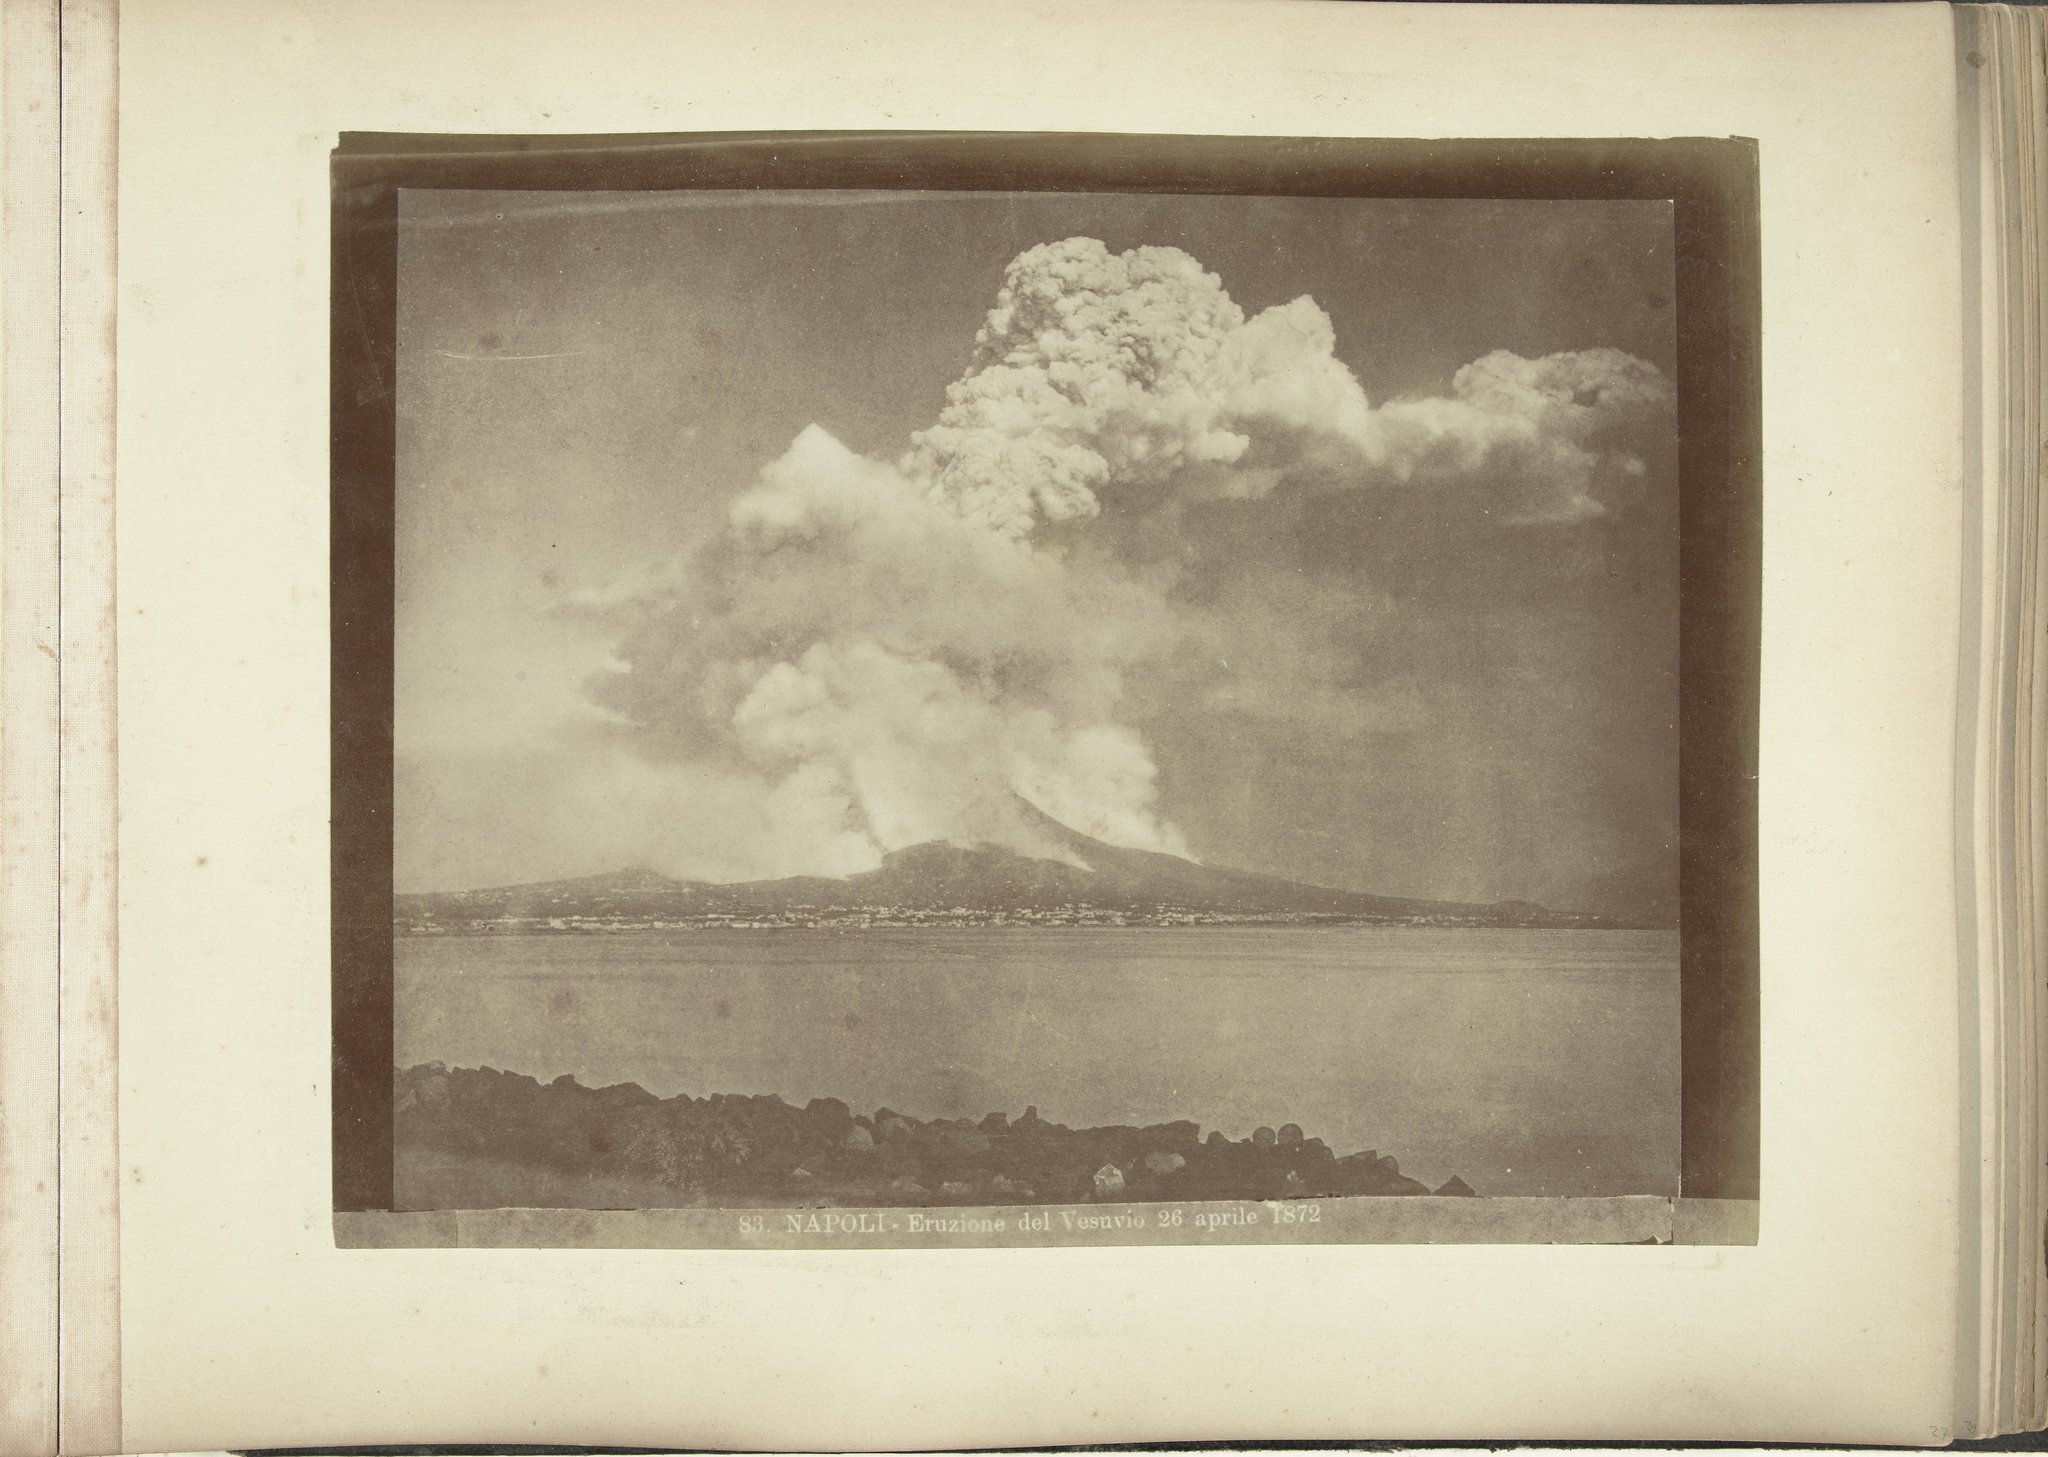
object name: album leaf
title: Napoli - Eruzione del Vesuvio 26 aprile 1872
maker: Anonymous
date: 1872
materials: paper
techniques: albumen print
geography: naples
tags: gulf, bay, eruption (of volcano), mount vesuvius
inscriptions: number: ‘83.’